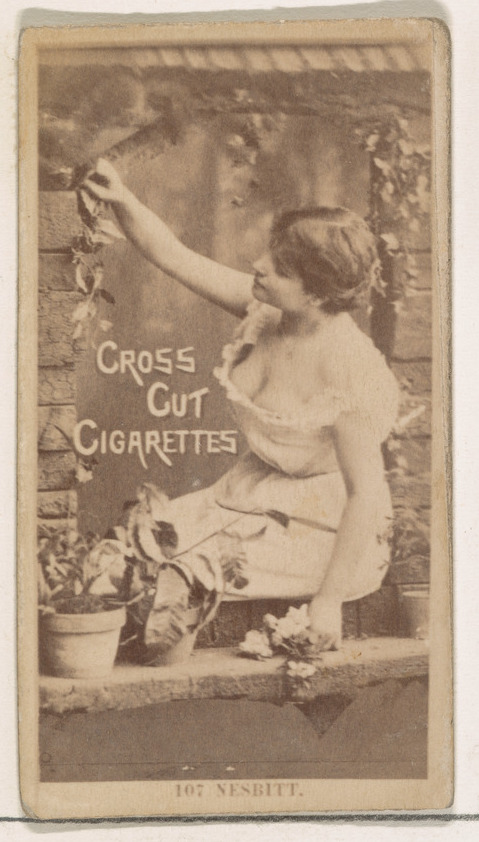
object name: print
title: Card Number 107, Nesbitt, from the Actors and Actresses series (N145-2) issued by Duke Sons & Co. to promote Cross Cut Cigarettes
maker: w. duke, sons & co.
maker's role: publisher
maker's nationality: american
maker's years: 1870-1920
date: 1880-1889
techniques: albumen silver print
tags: women,actresses